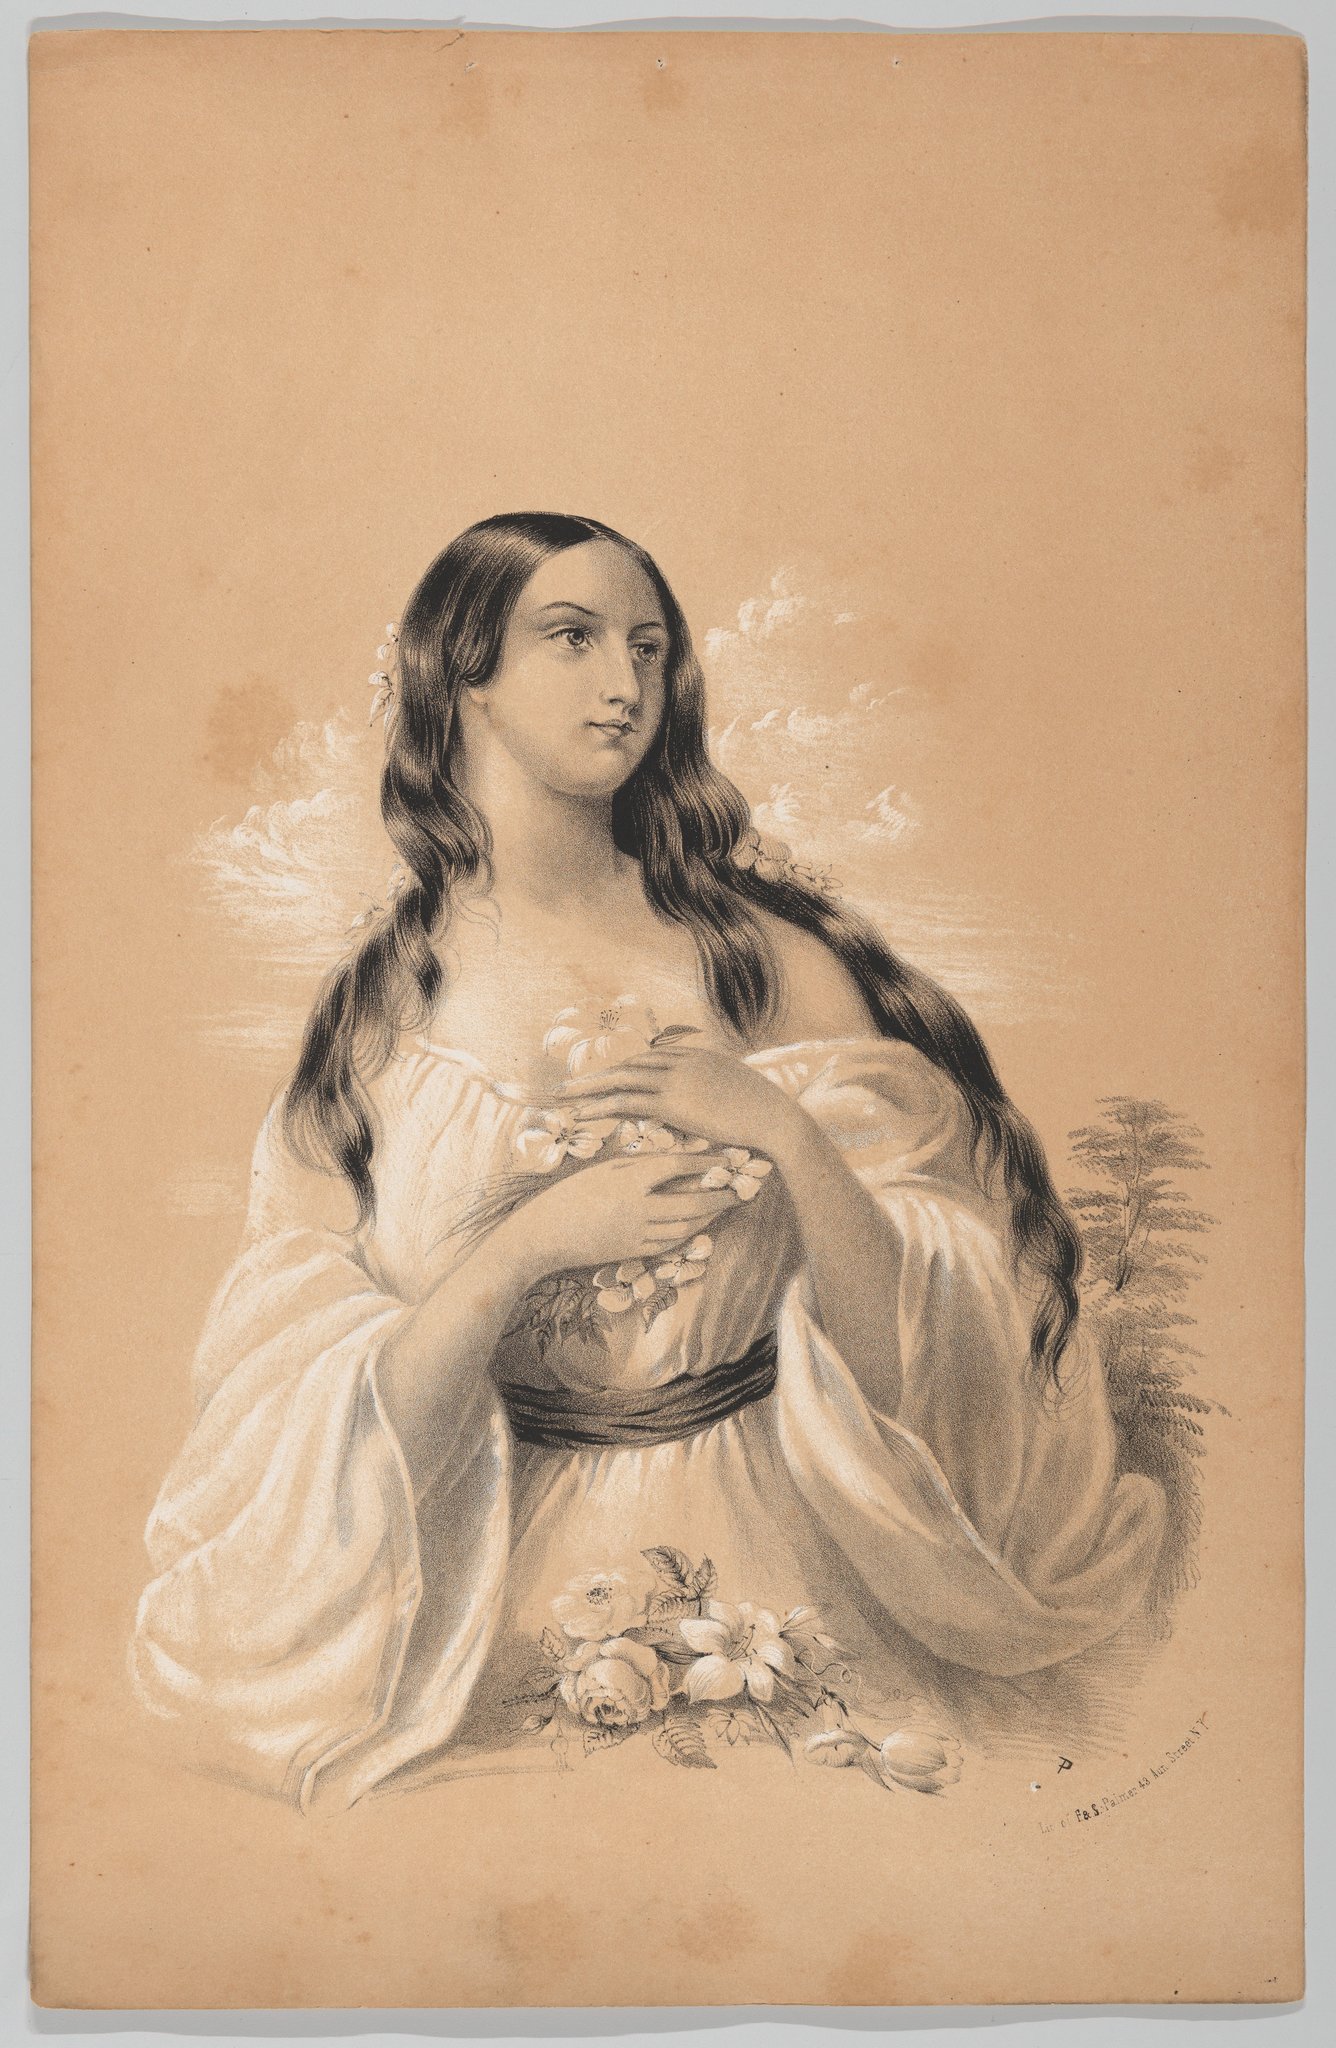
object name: book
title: Woman Holding Flowers, in The New York Drawing Book, Containing a Series of Original Designs and Sketches of American Scenery, No. 2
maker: frances flora bond palmer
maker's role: artist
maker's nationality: american, born england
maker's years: 1812-1876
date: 1847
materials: ink, paper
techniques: lithograph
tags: women